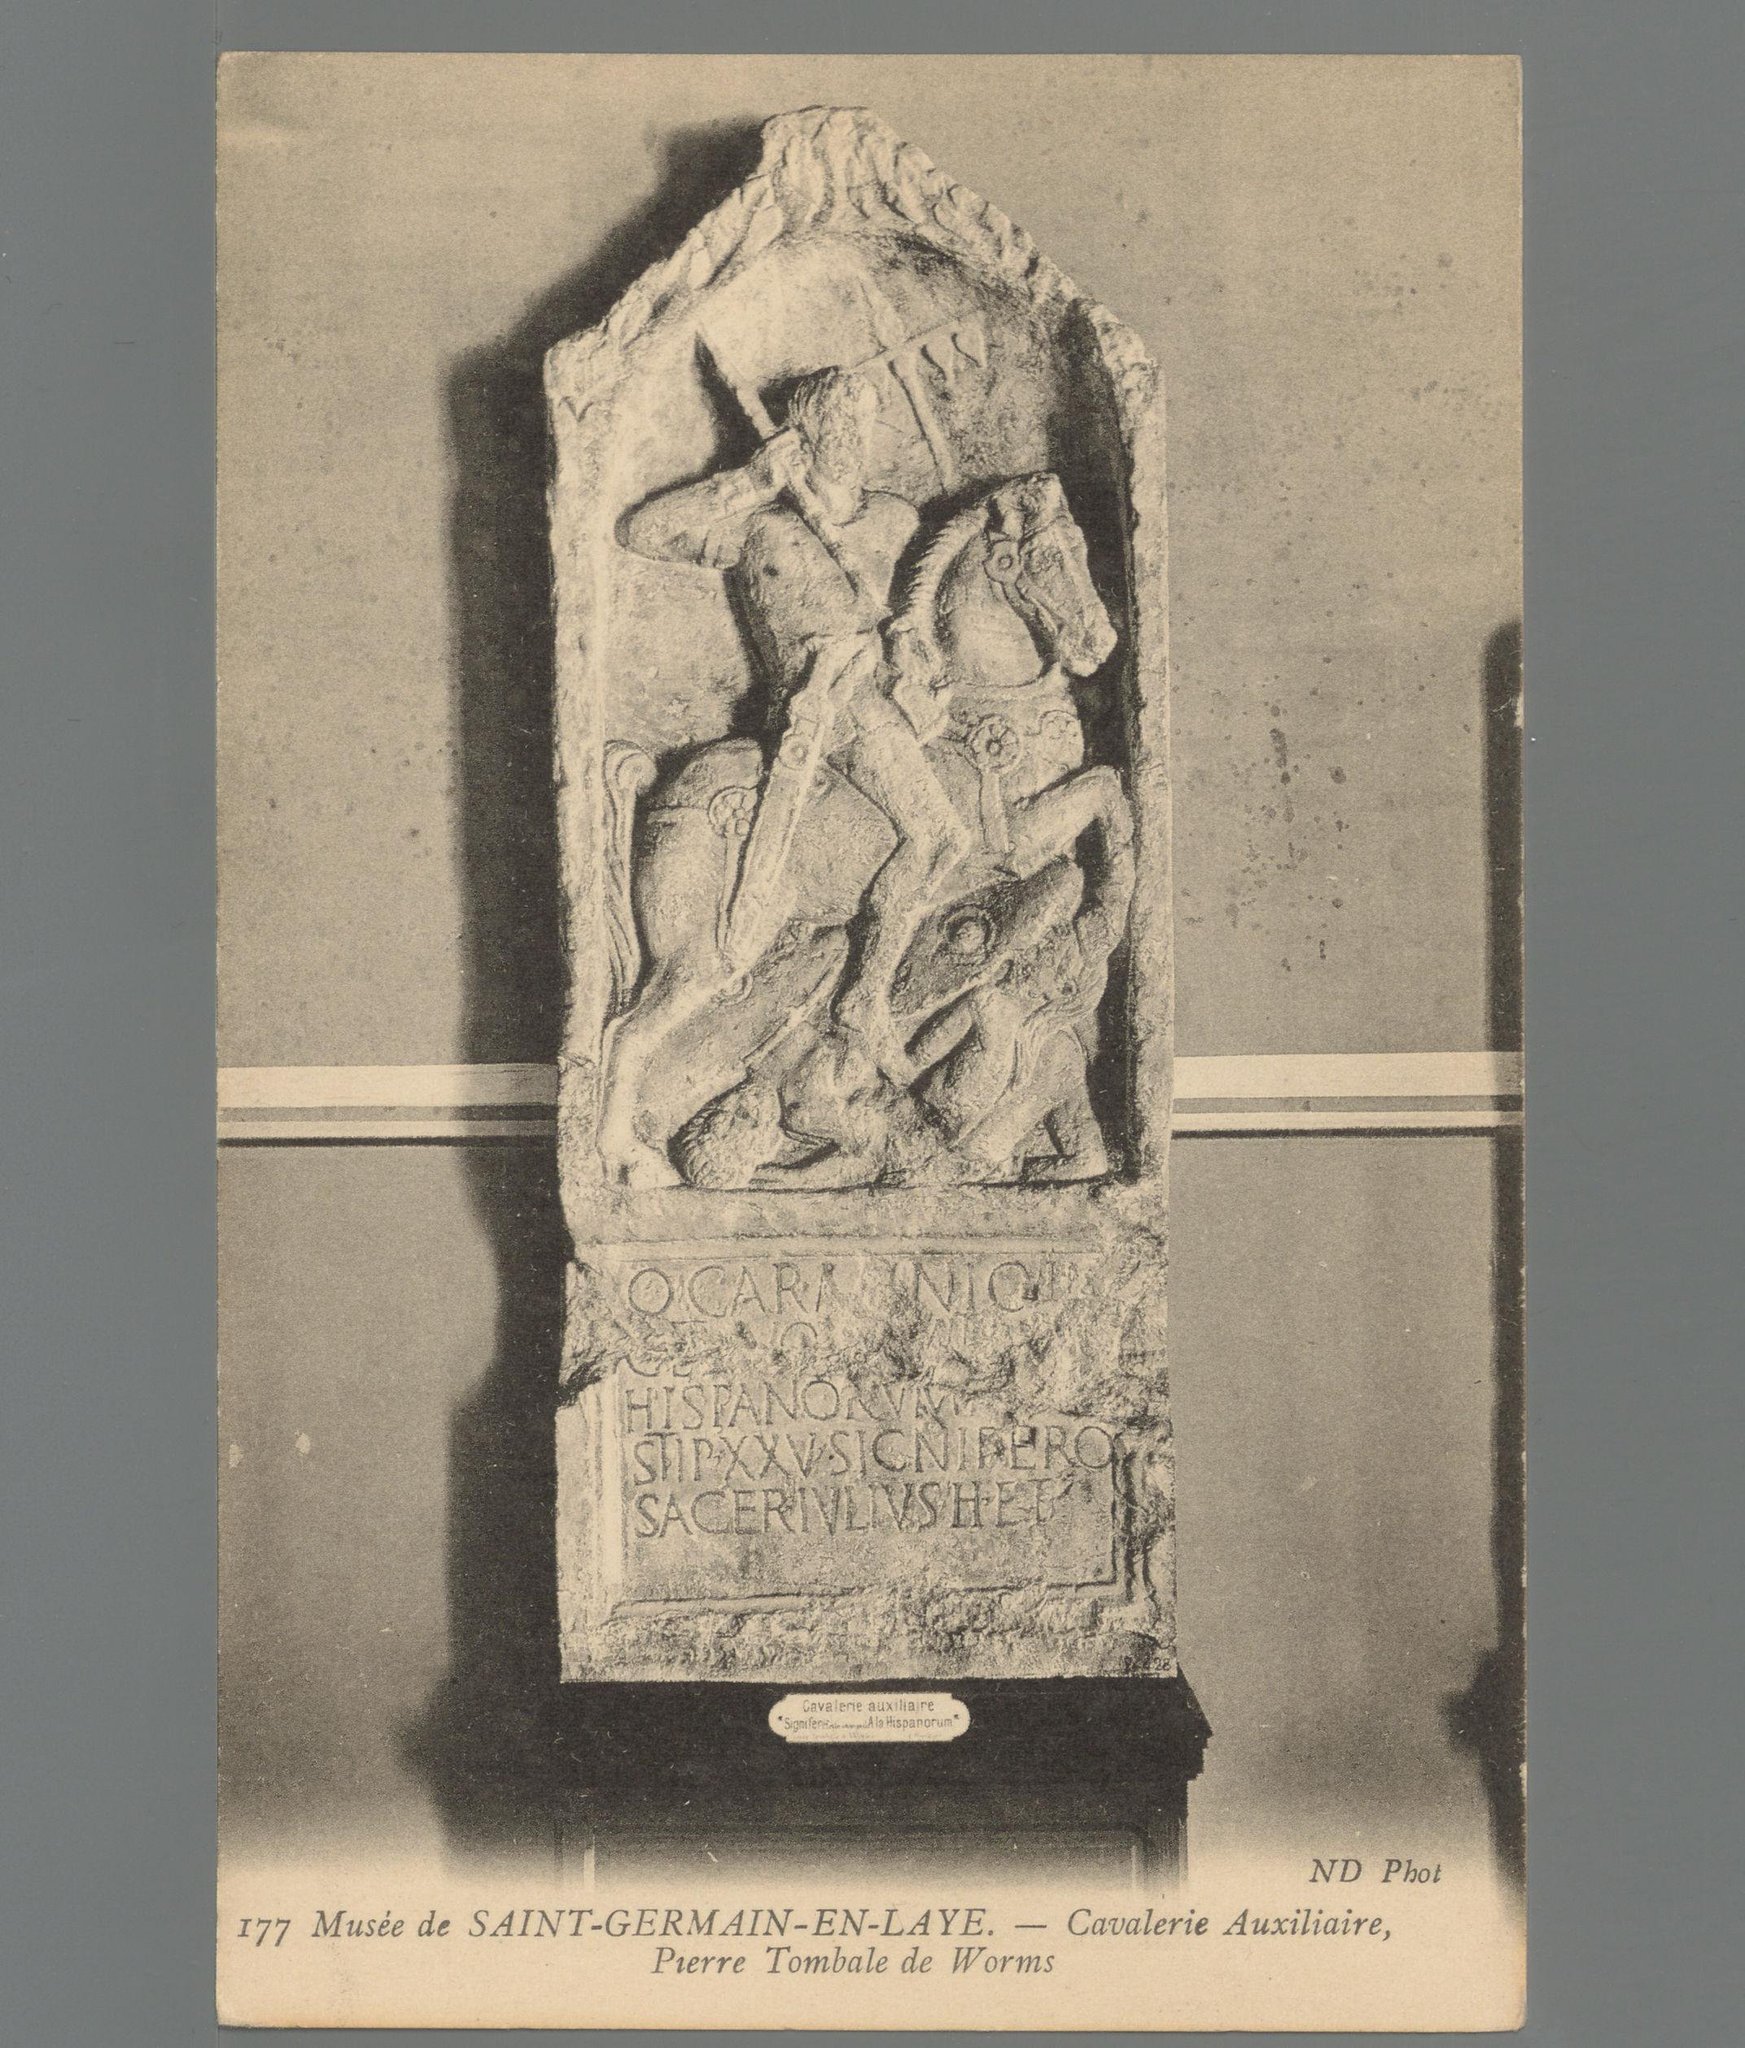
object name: ansichtkaart, prentbriefkaart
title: Cavalerie Auxiliaire, Pierre Tombale de Worms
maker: Anonymous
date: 1904-1906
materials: cardboard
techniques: photograph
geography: saint-germain-en-laye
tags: upright gravestone, permanent exhibition, museum